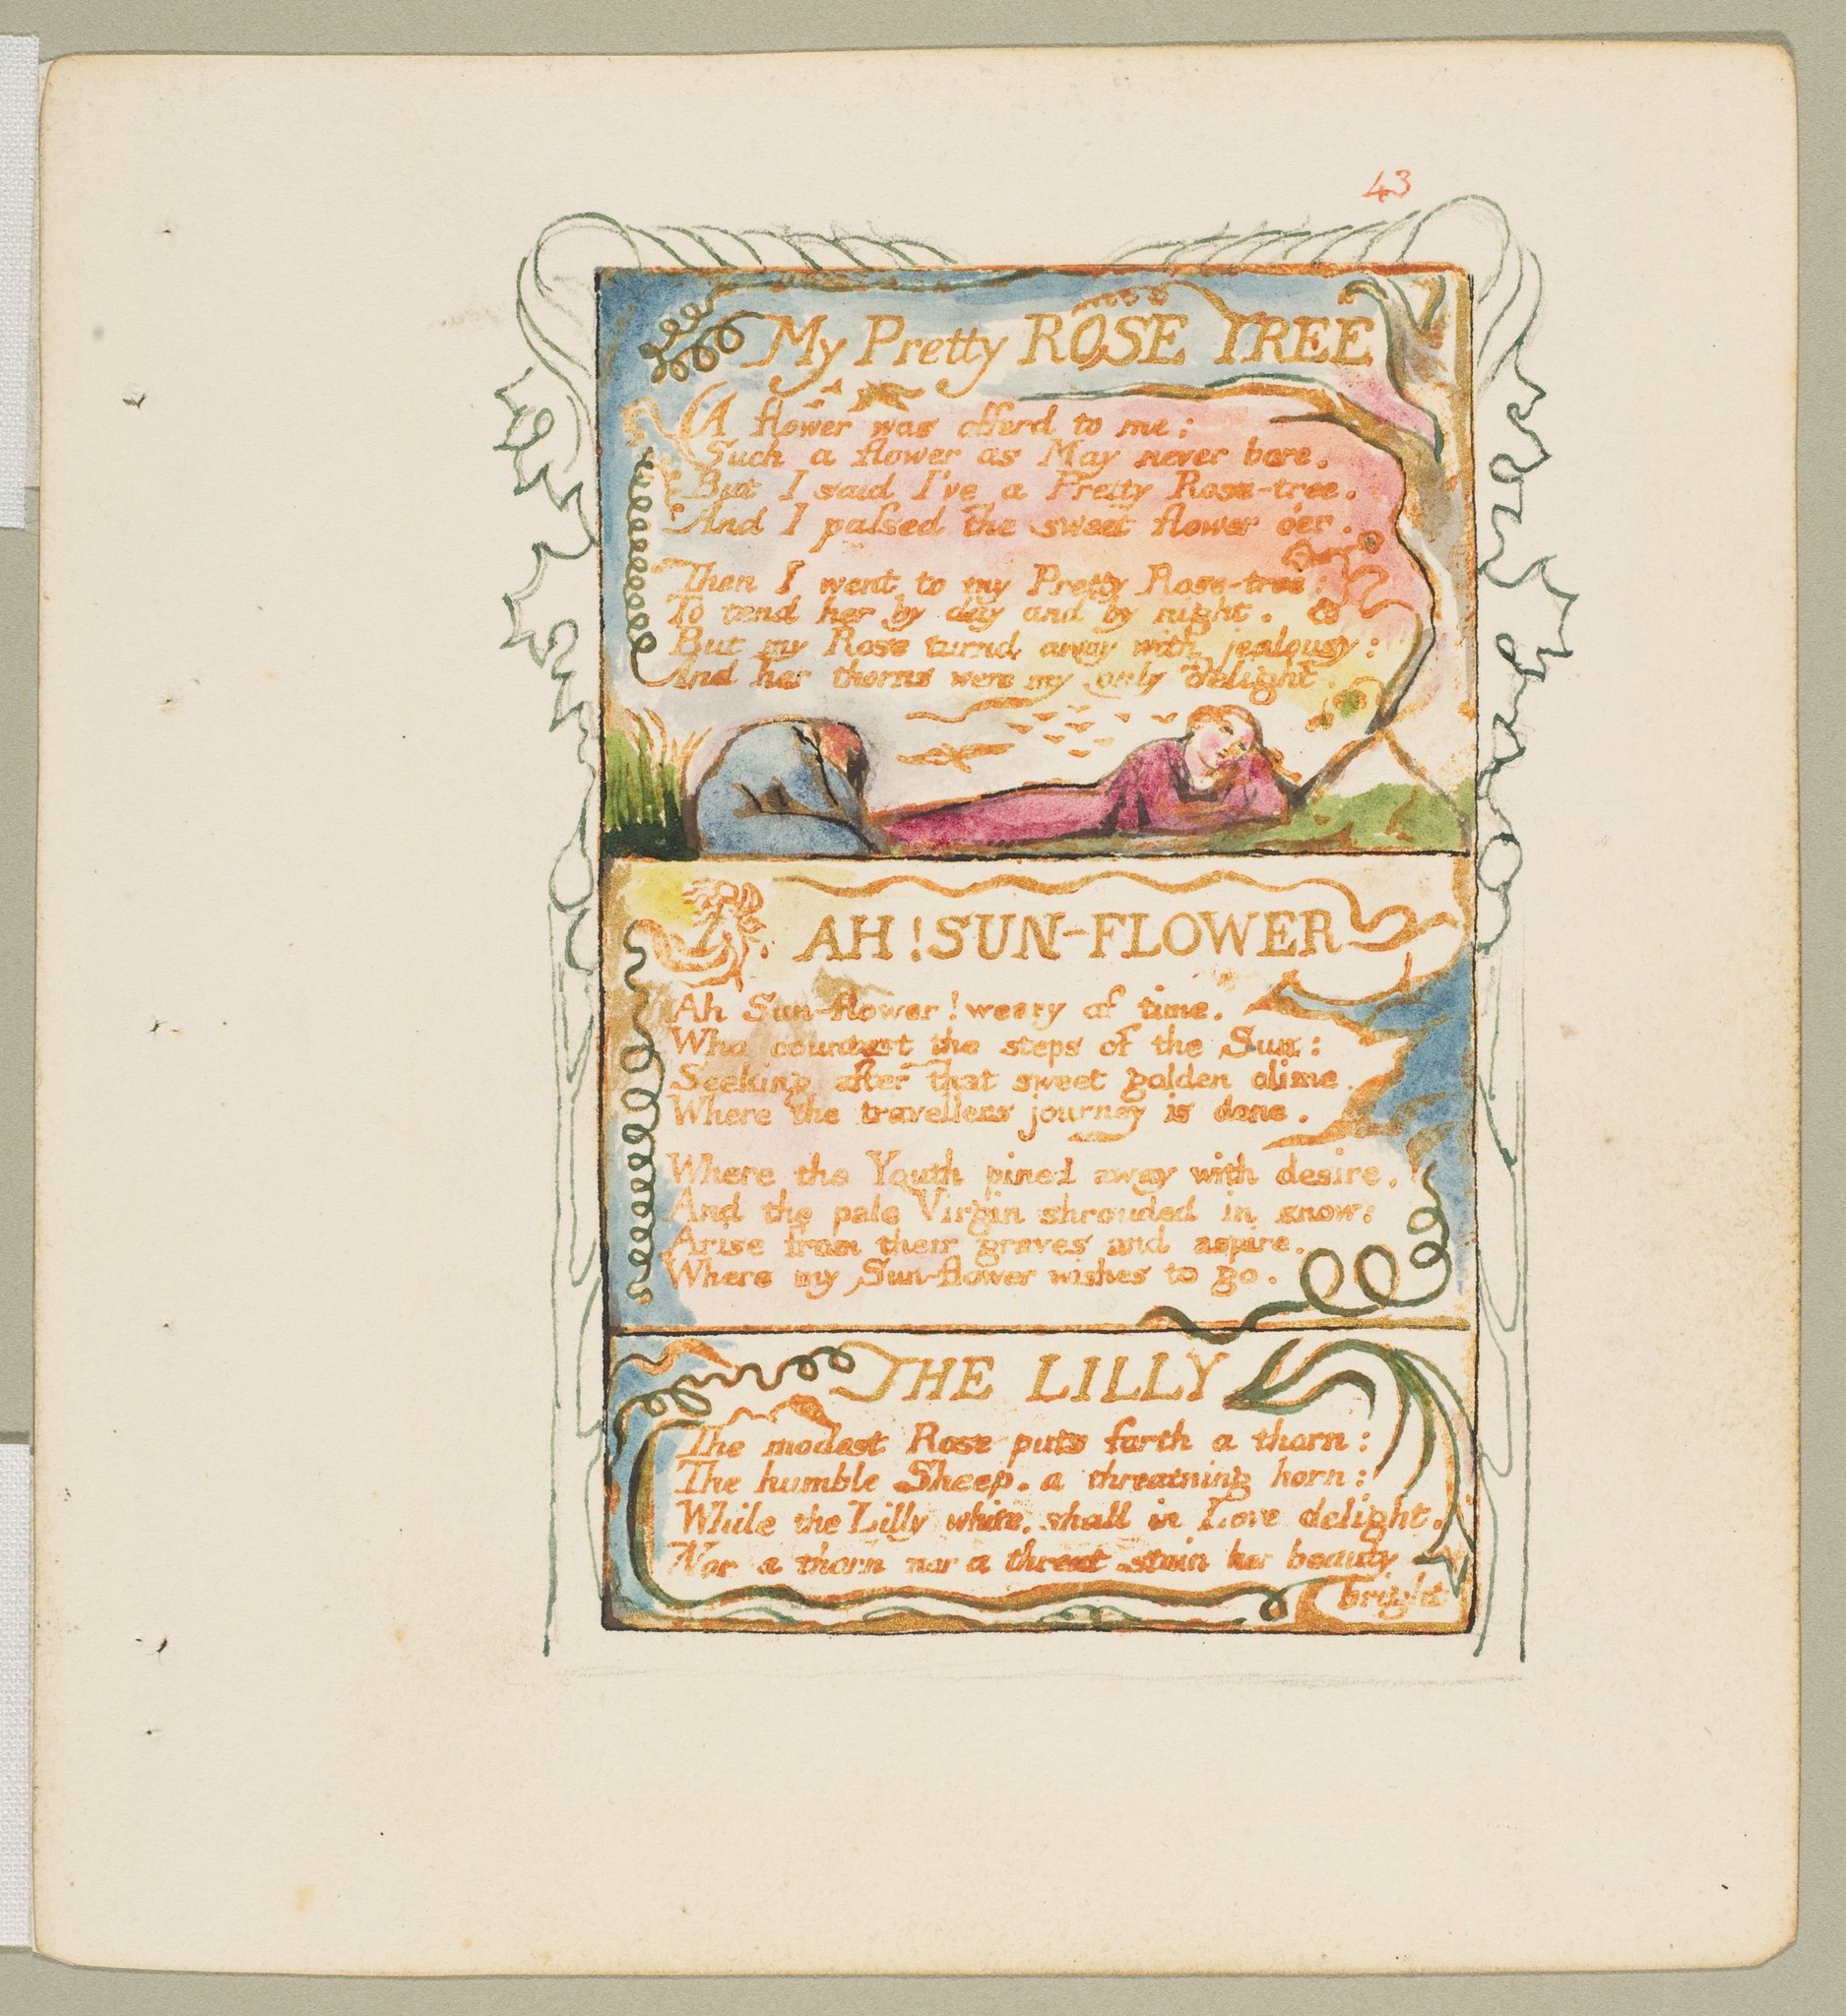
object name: print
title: Songs of Experience: My Pretty Rose Tree, Ah! Sun-Flower, The Lilly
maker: william blake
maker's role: artist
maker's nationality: british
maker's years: 1757-1827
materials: gold, ink, shell, watercolor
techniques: etching, hand coloring, printing, relief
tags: poetry,women